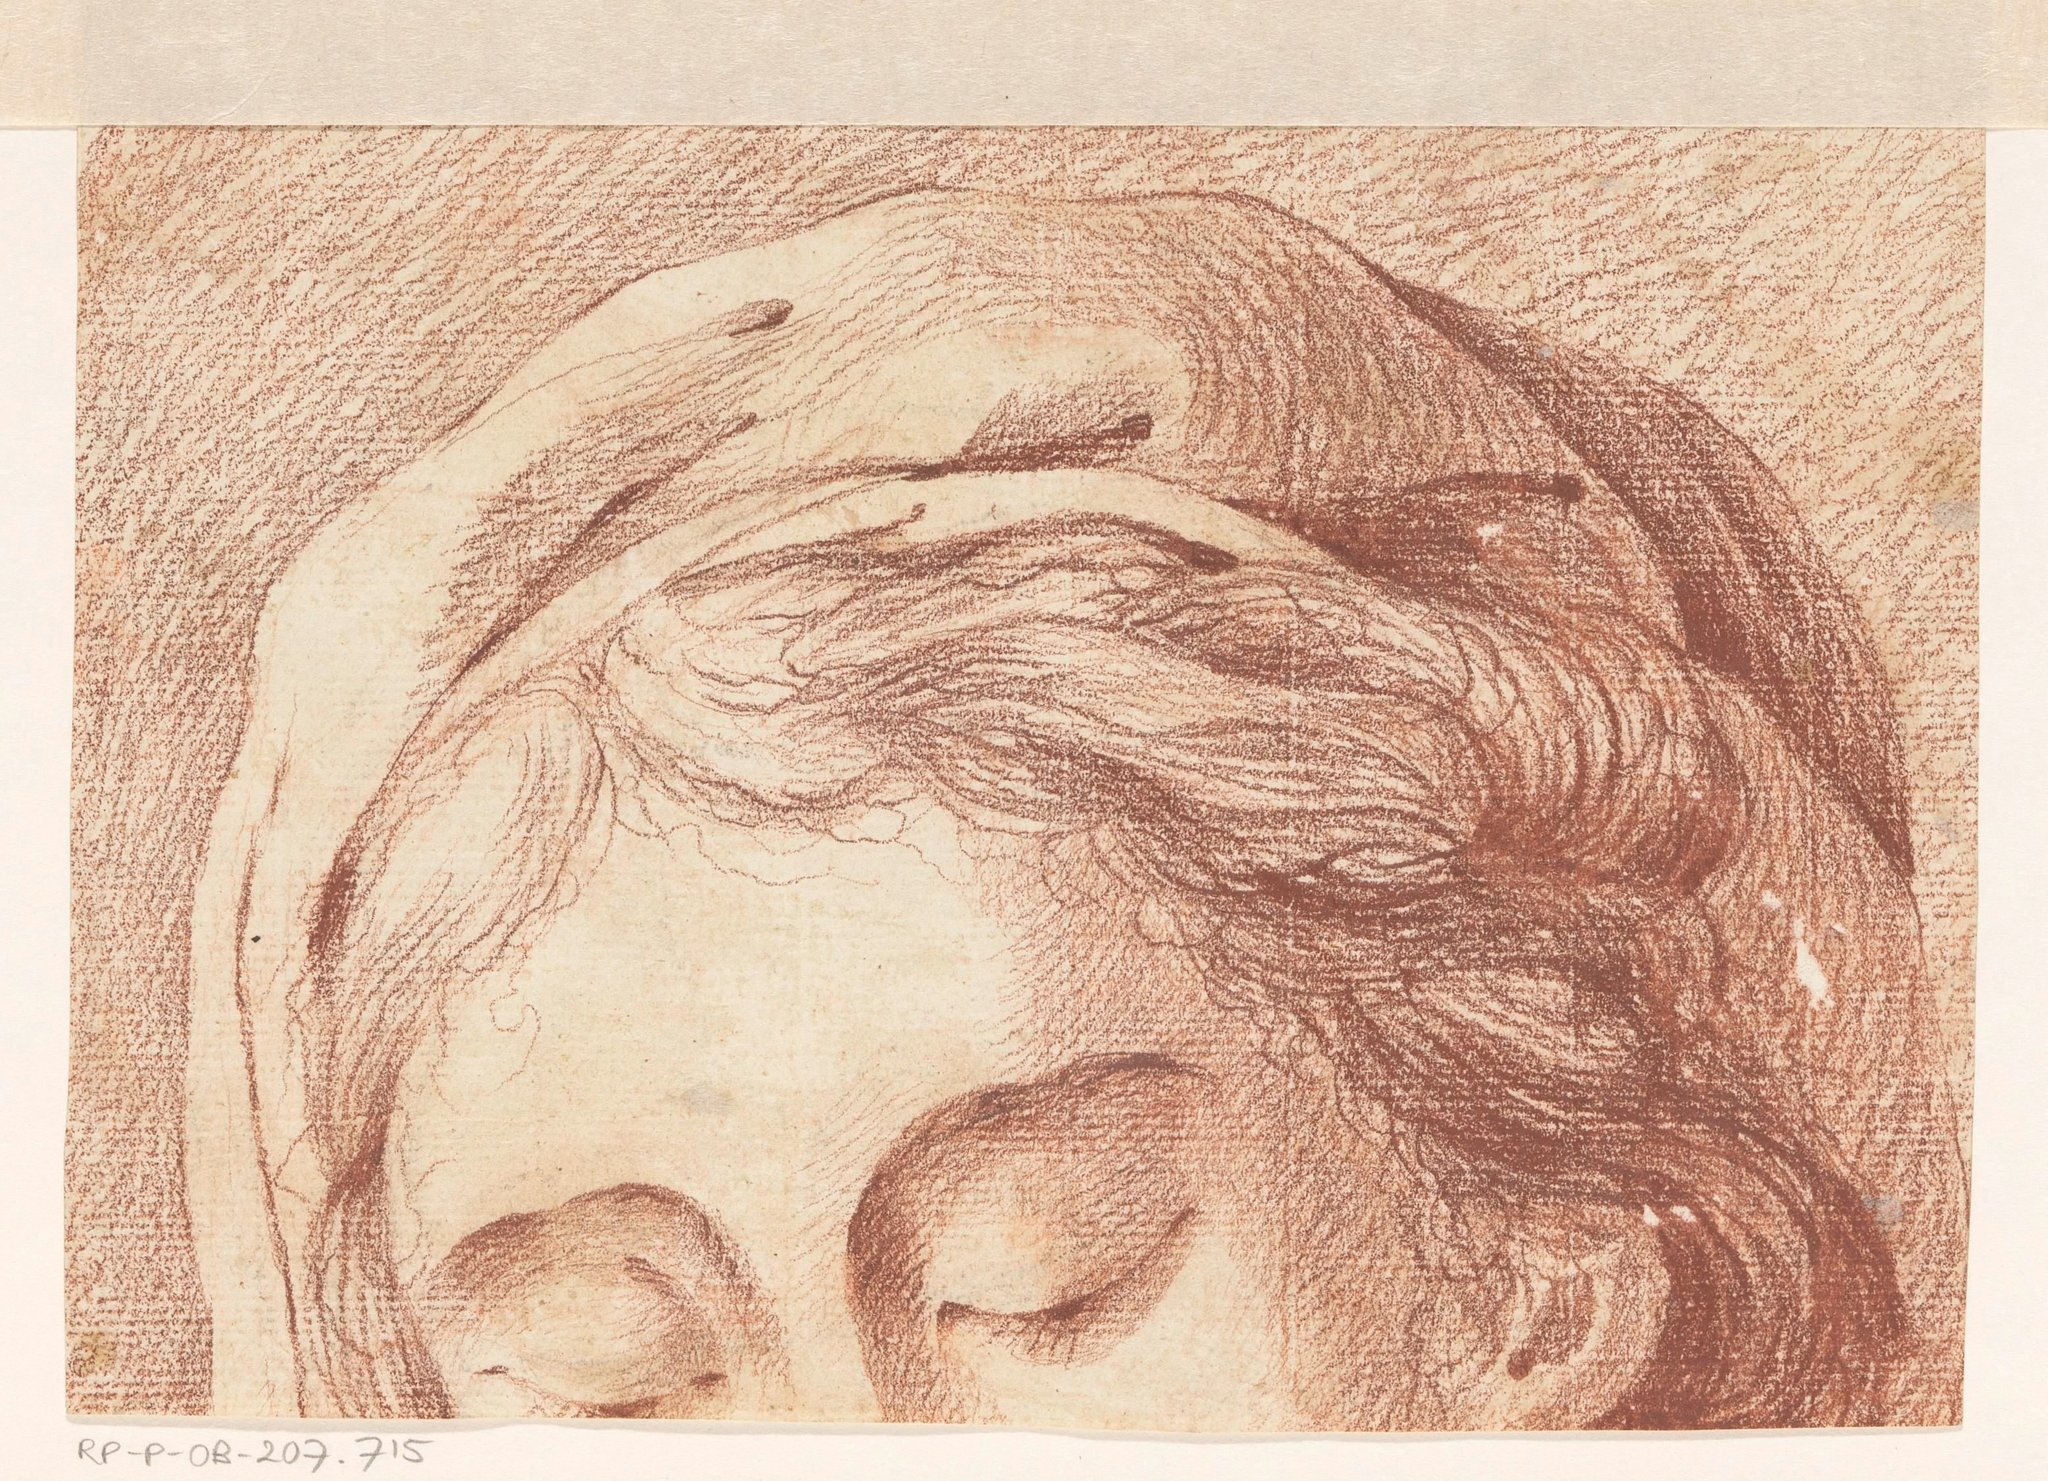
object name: drawing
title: Vrouwenhoofd met muts en gesloten ogen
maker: Anonymous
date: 1700-1799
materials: chalk, paper, pencil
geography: italy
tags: head (human) (+ three-quarter view), eyes closed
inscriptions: collector's mark: Lugt 2228